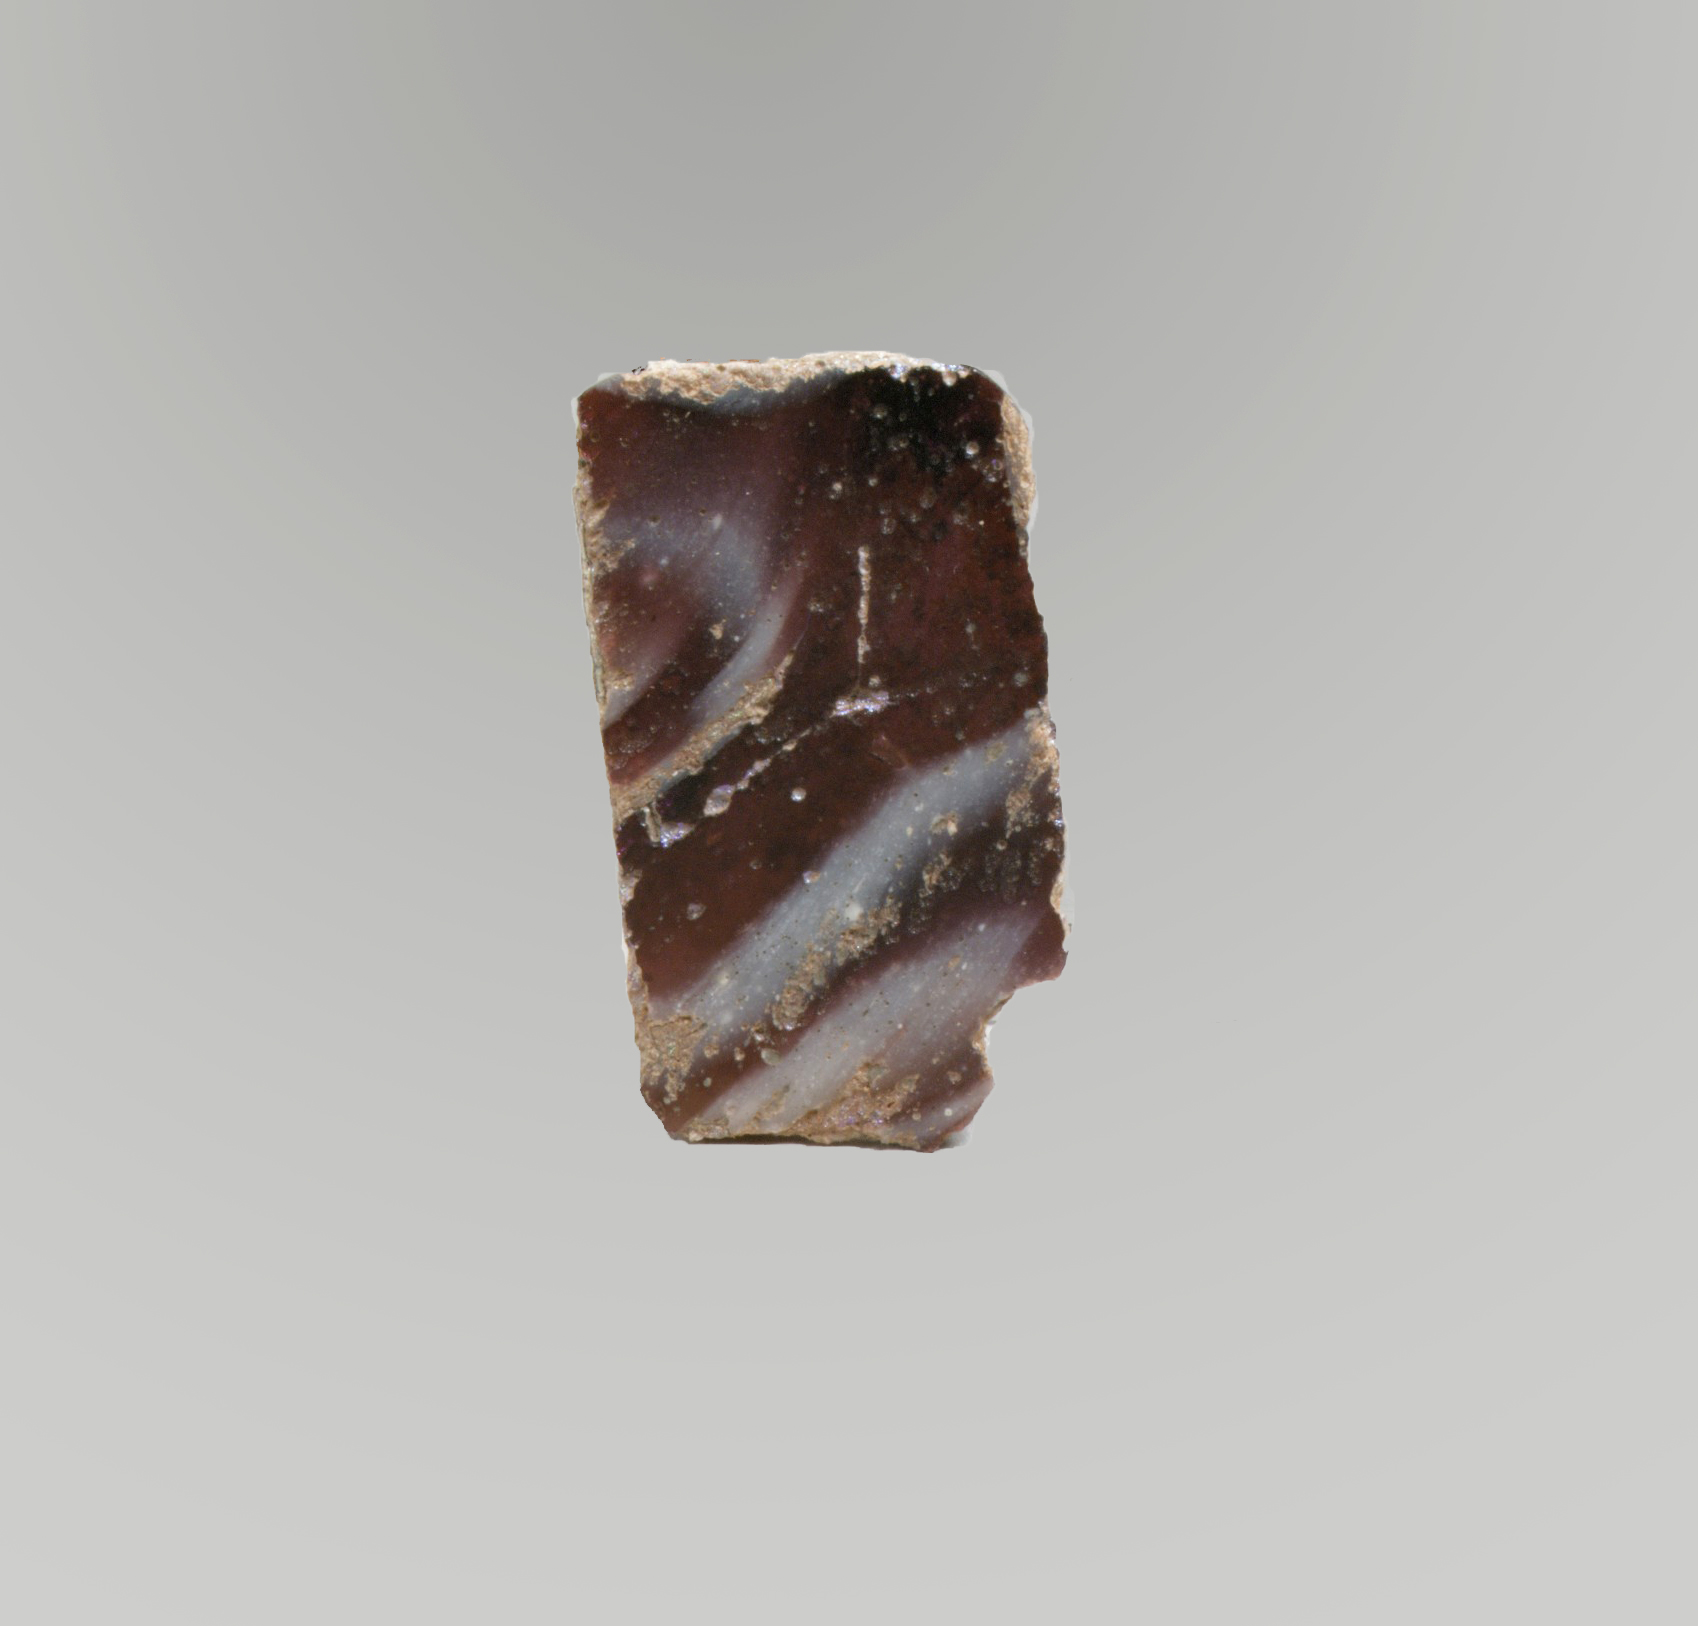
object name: fragment, mosaic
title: Glass mosaic inlay fragment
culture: roman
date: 34 BCE-33 CE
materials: glass